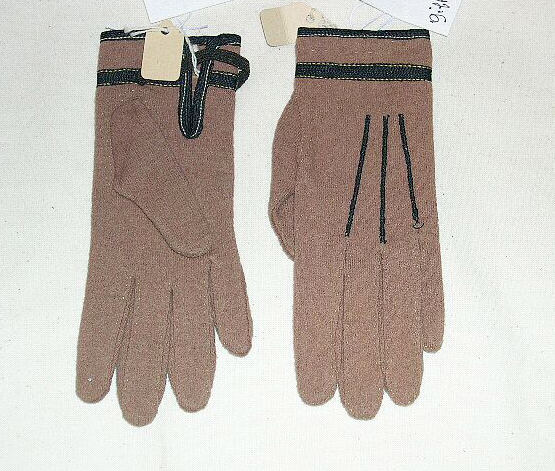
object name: glove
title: Gloves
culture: american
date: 1862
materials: wool